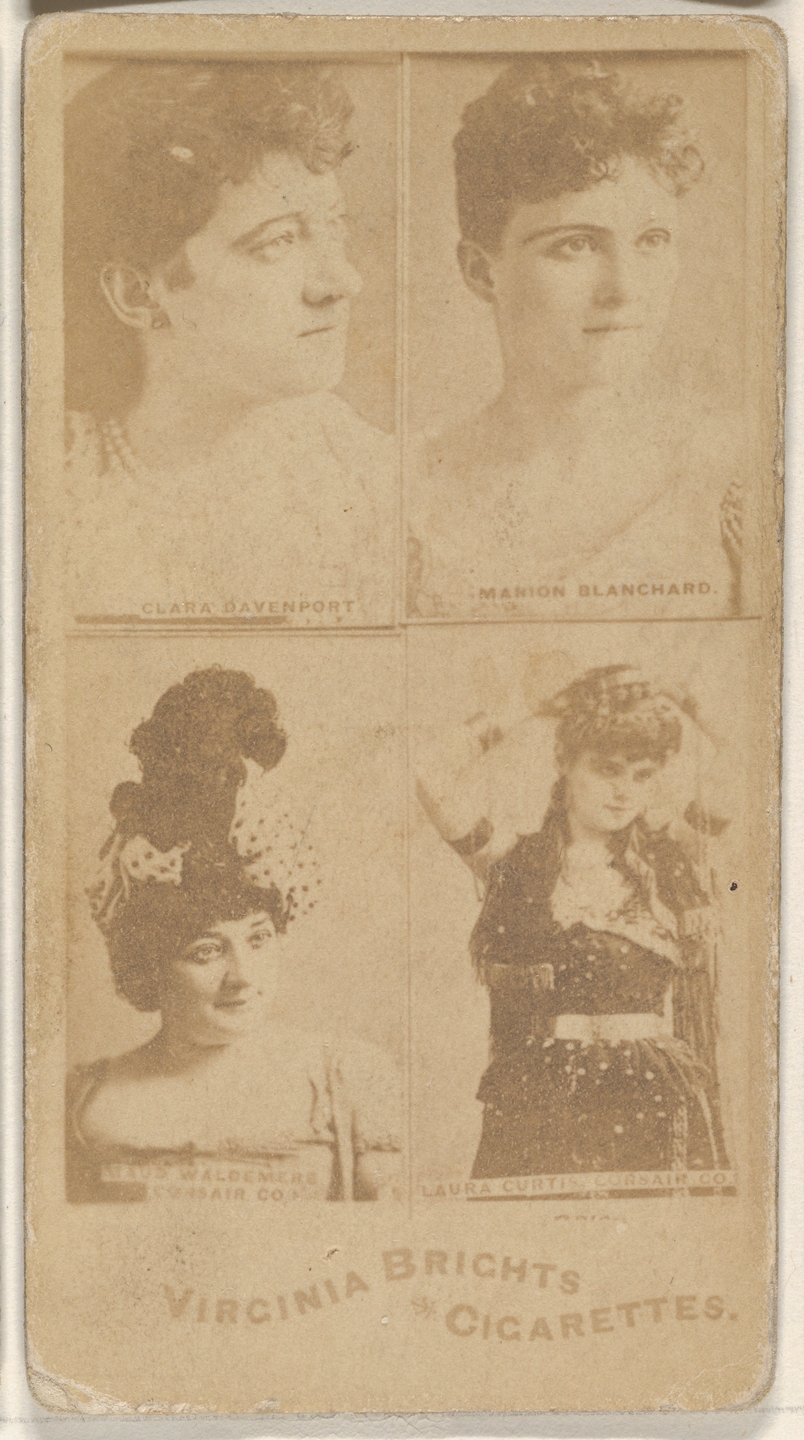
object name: photograph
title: Clara Davenport/ Marion Blanchard/ Maud Waldemere, Corsair Co./ Laura Curtis, Corsair Co., from the Actors and Actresses series (N45, Type 4) for Virginia Brights Cigarettes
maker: allen & ginter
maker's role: publisher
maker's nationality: american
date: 1888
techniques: albumen silver print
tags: portraits,women,actresses